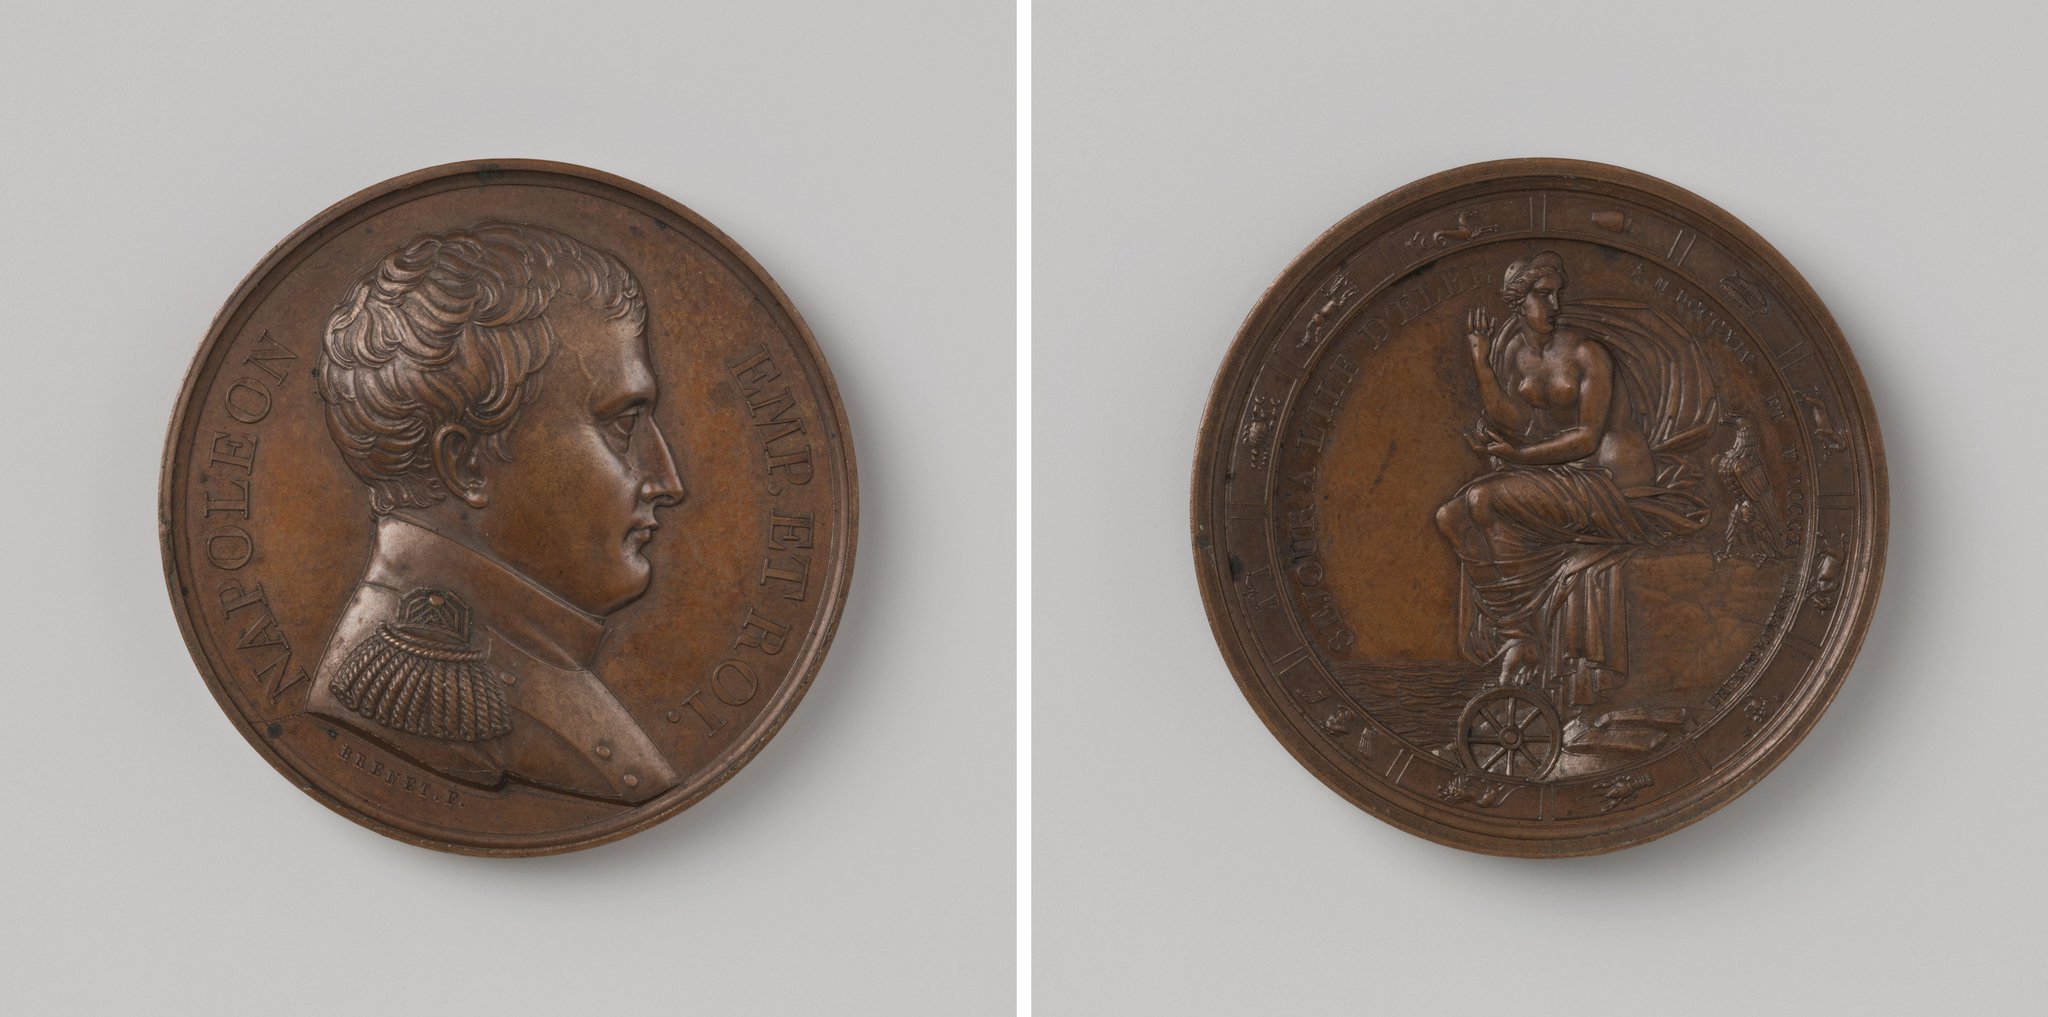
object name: history medal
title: Verblijf van Napoleon I Bonaparte, keizer der Fransen op Elba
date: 1815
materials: bronze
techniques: striking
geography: paris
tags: napoleon i (emperor of the french)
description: Bronzen penning. Voorzijde: borststuk man binnen omschrift. Keerzijde: gesluierde vrouw zittend naast adelaar met haar voet op rad rustend; op achtergrond zee binnen omschrift en dierenriem